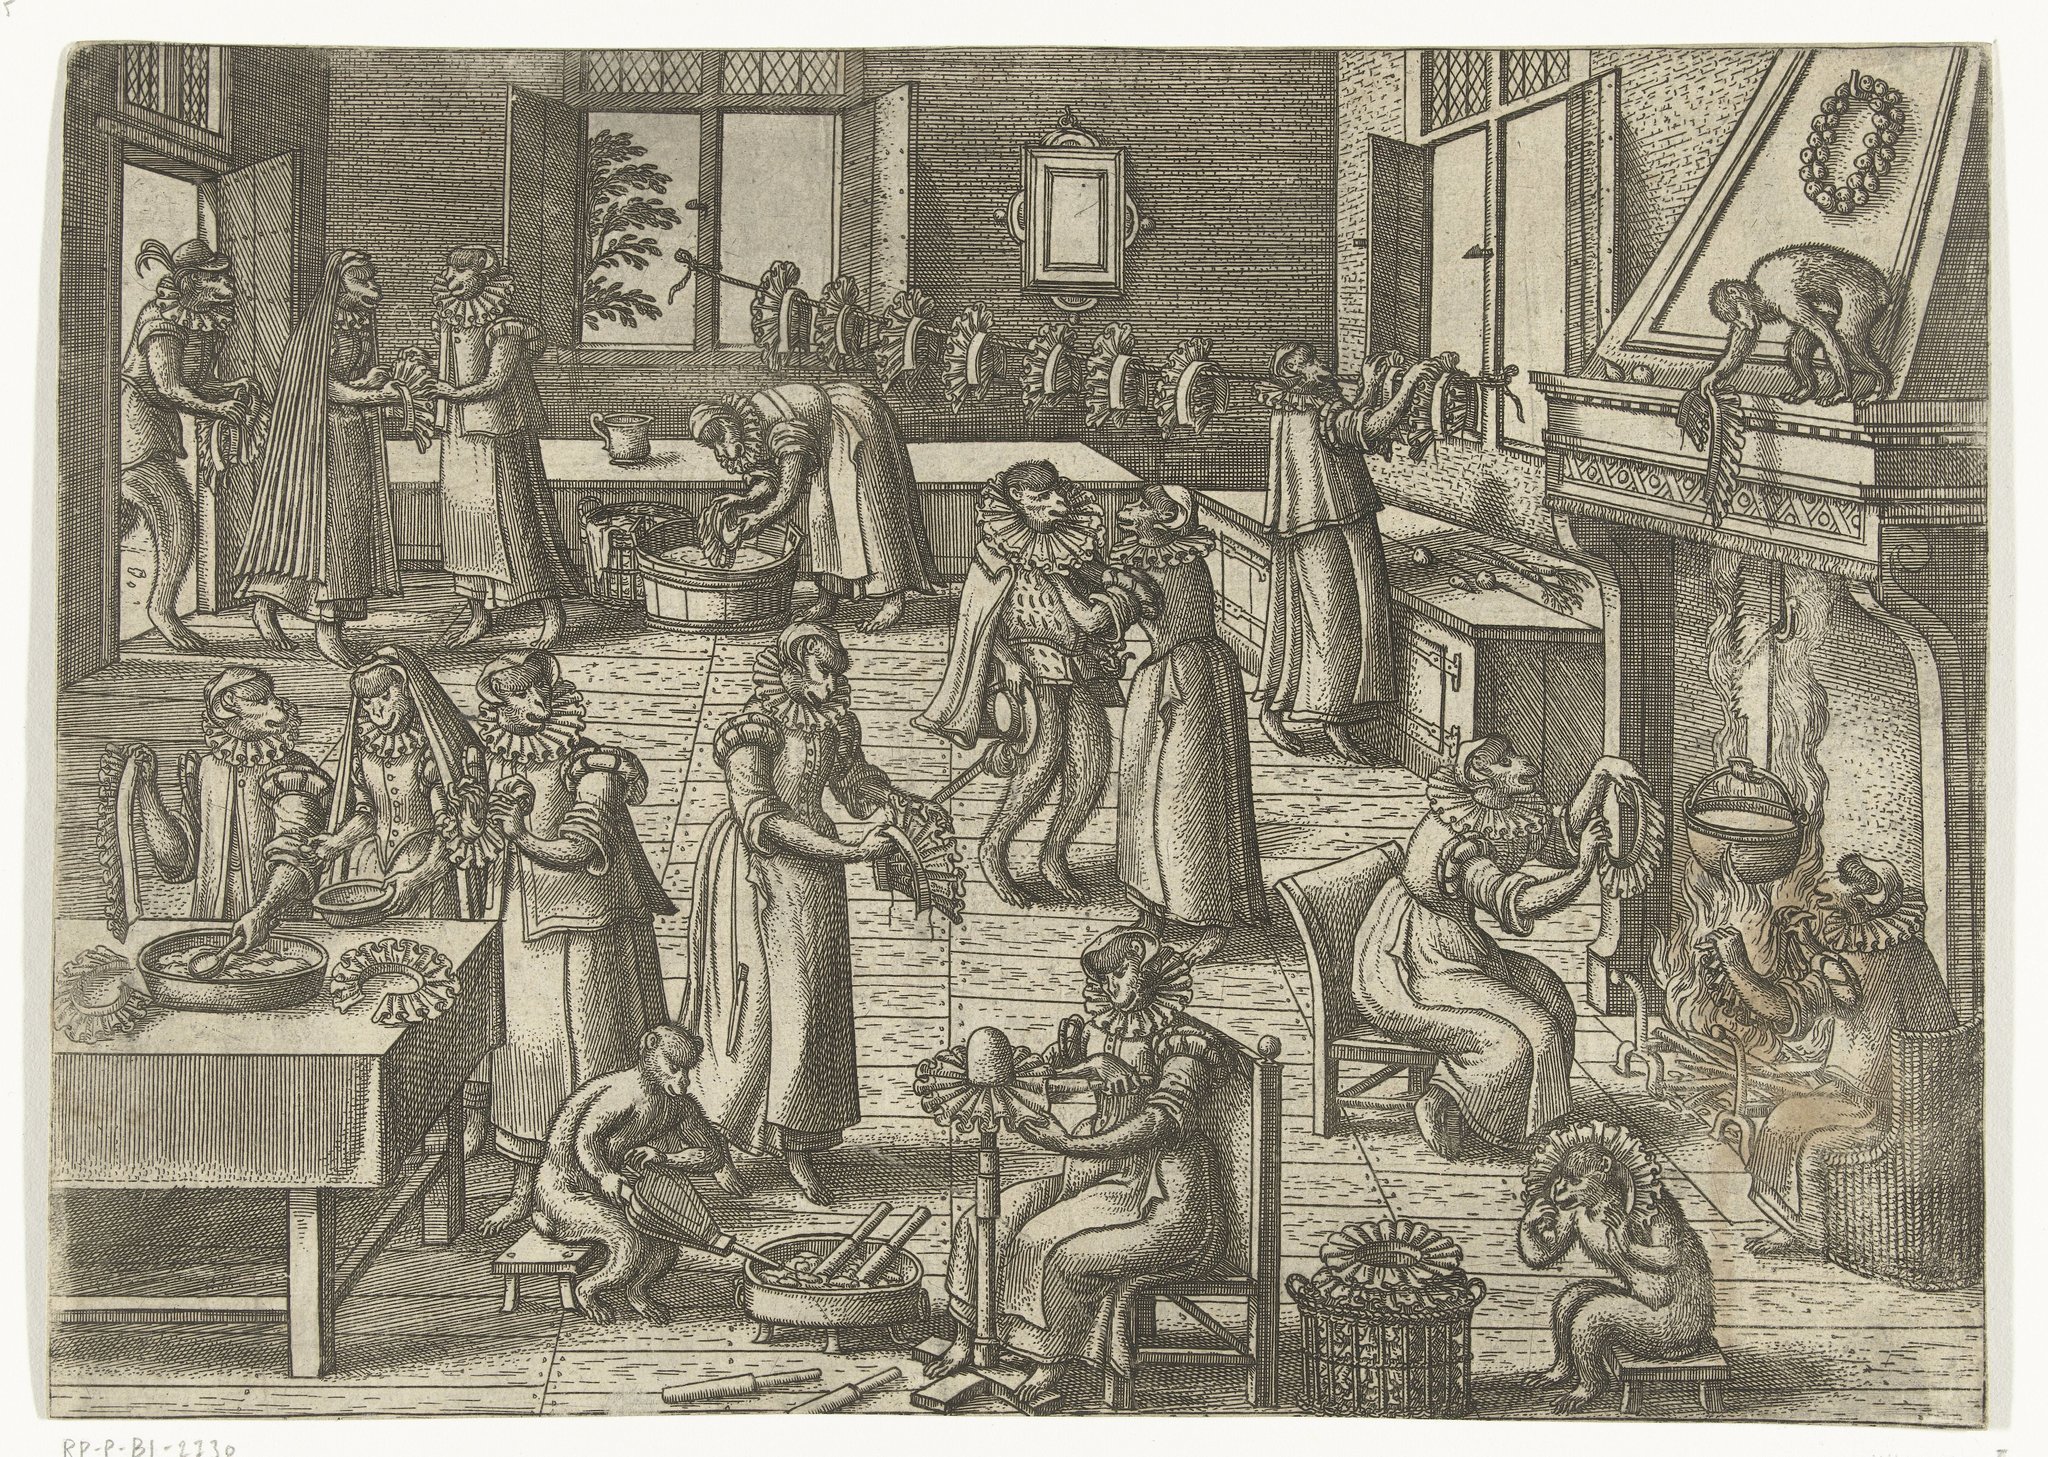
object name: print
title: Kragenatelier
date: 1545-1608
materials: paper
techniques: etching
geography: antwerp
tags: monkeys, apes, neck-gear ~ clothing (with name), animals acting as human beings, accessories and implements ~ laundering, e.g. clothes-peg, drying frame, (empty) washing line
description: Een 16de-eeuwse wasserij voor kragen, waarin de mensen en hun handelingen zijn voorgesteld door apen. In de ruimte ontvangen apen klanten, terwijl kragen worden gewassen, gedroogd en weer opgezet.